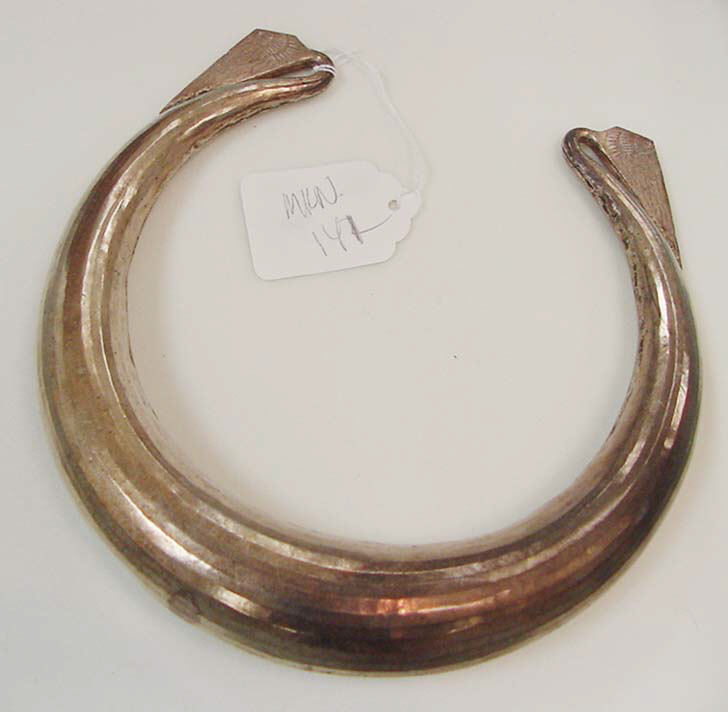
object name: necklace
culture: chinese, minority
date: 1801-1900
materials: silver